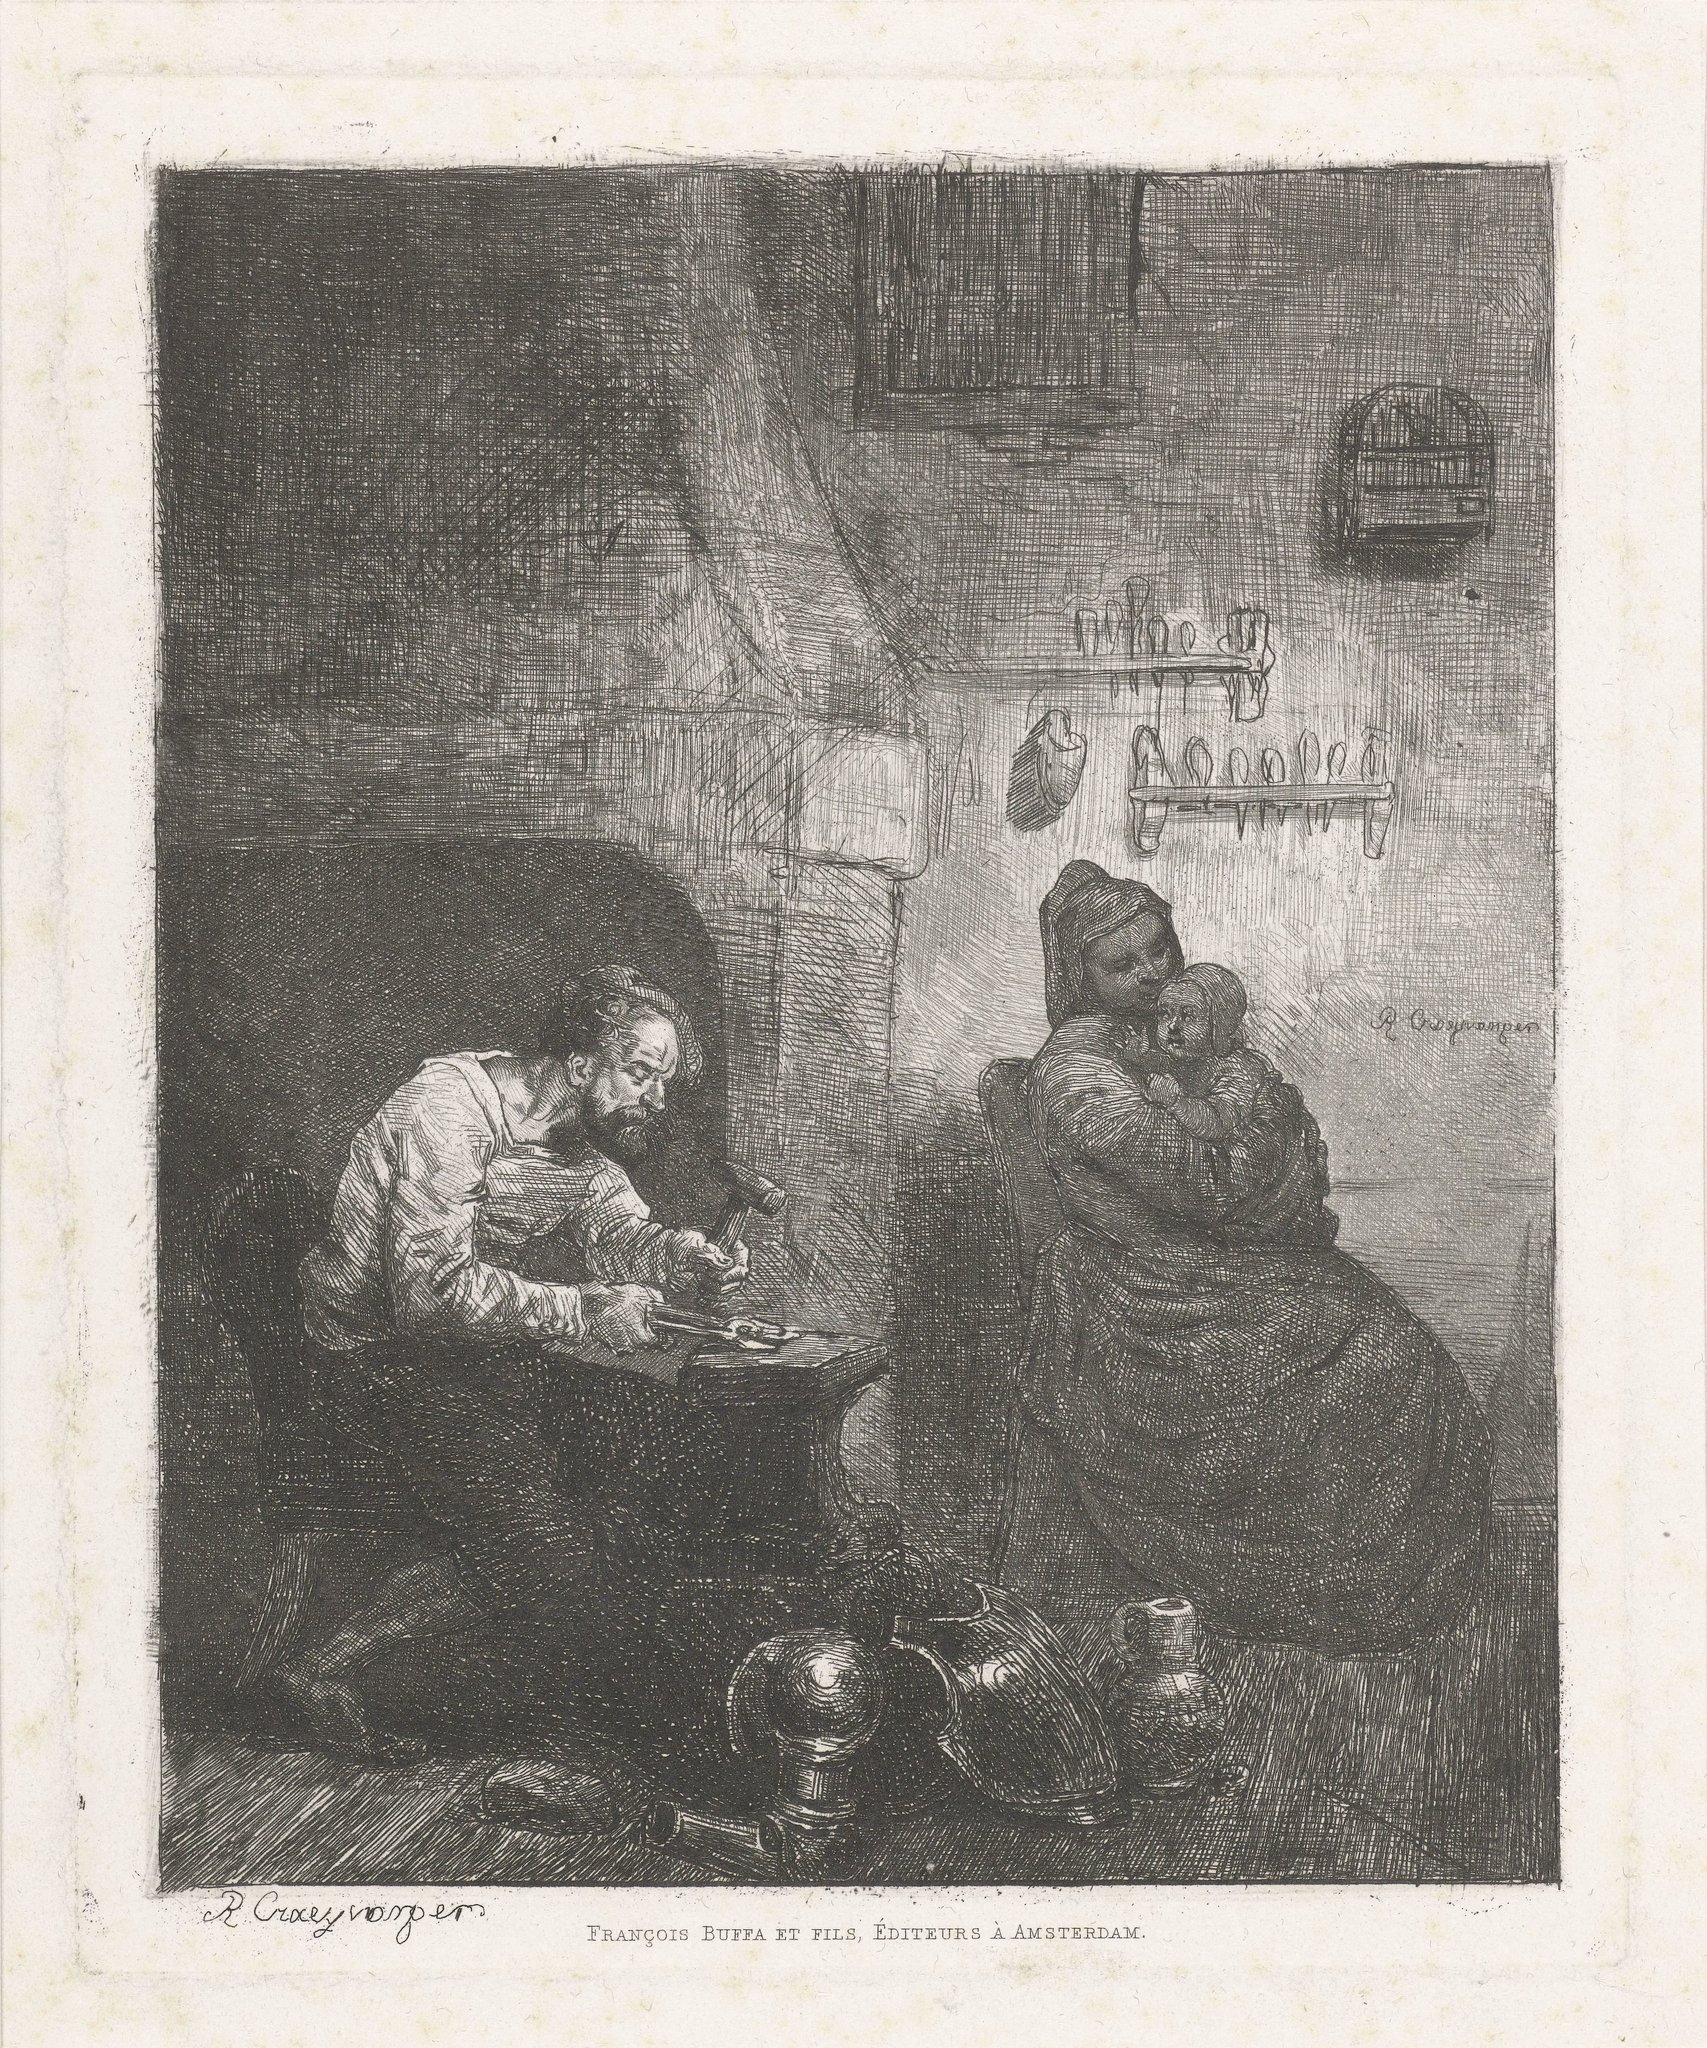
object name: print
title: Wapensmid aan het werk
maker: reinier craeyvanger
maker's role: draughtsman, print maker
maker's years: 1812-1880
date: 1822-1880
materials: paper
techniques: etching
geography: amsterdam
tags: smith, blacksmith (+ indoors; in laboratory, factory, barn, etc.), armour, mother and baby or young child, handicrafts ~ metal, forging (industrial process)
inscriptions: collector's mark: Lugt 2228, collector's mark: Lugt 2760, caption: ‘Francois Buffa et Fils, Éditeurs à Amsterdam’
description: Een wapensmid zit op een stoel voor een aambeeld en bewerkt met een hamer een voorwerp dat hij in een tang vasthoudt. Naast het aambeeld liggen delen van een harnas. Achter hem een haard. Rechts zit zijn vrouw met een kind in de armen.